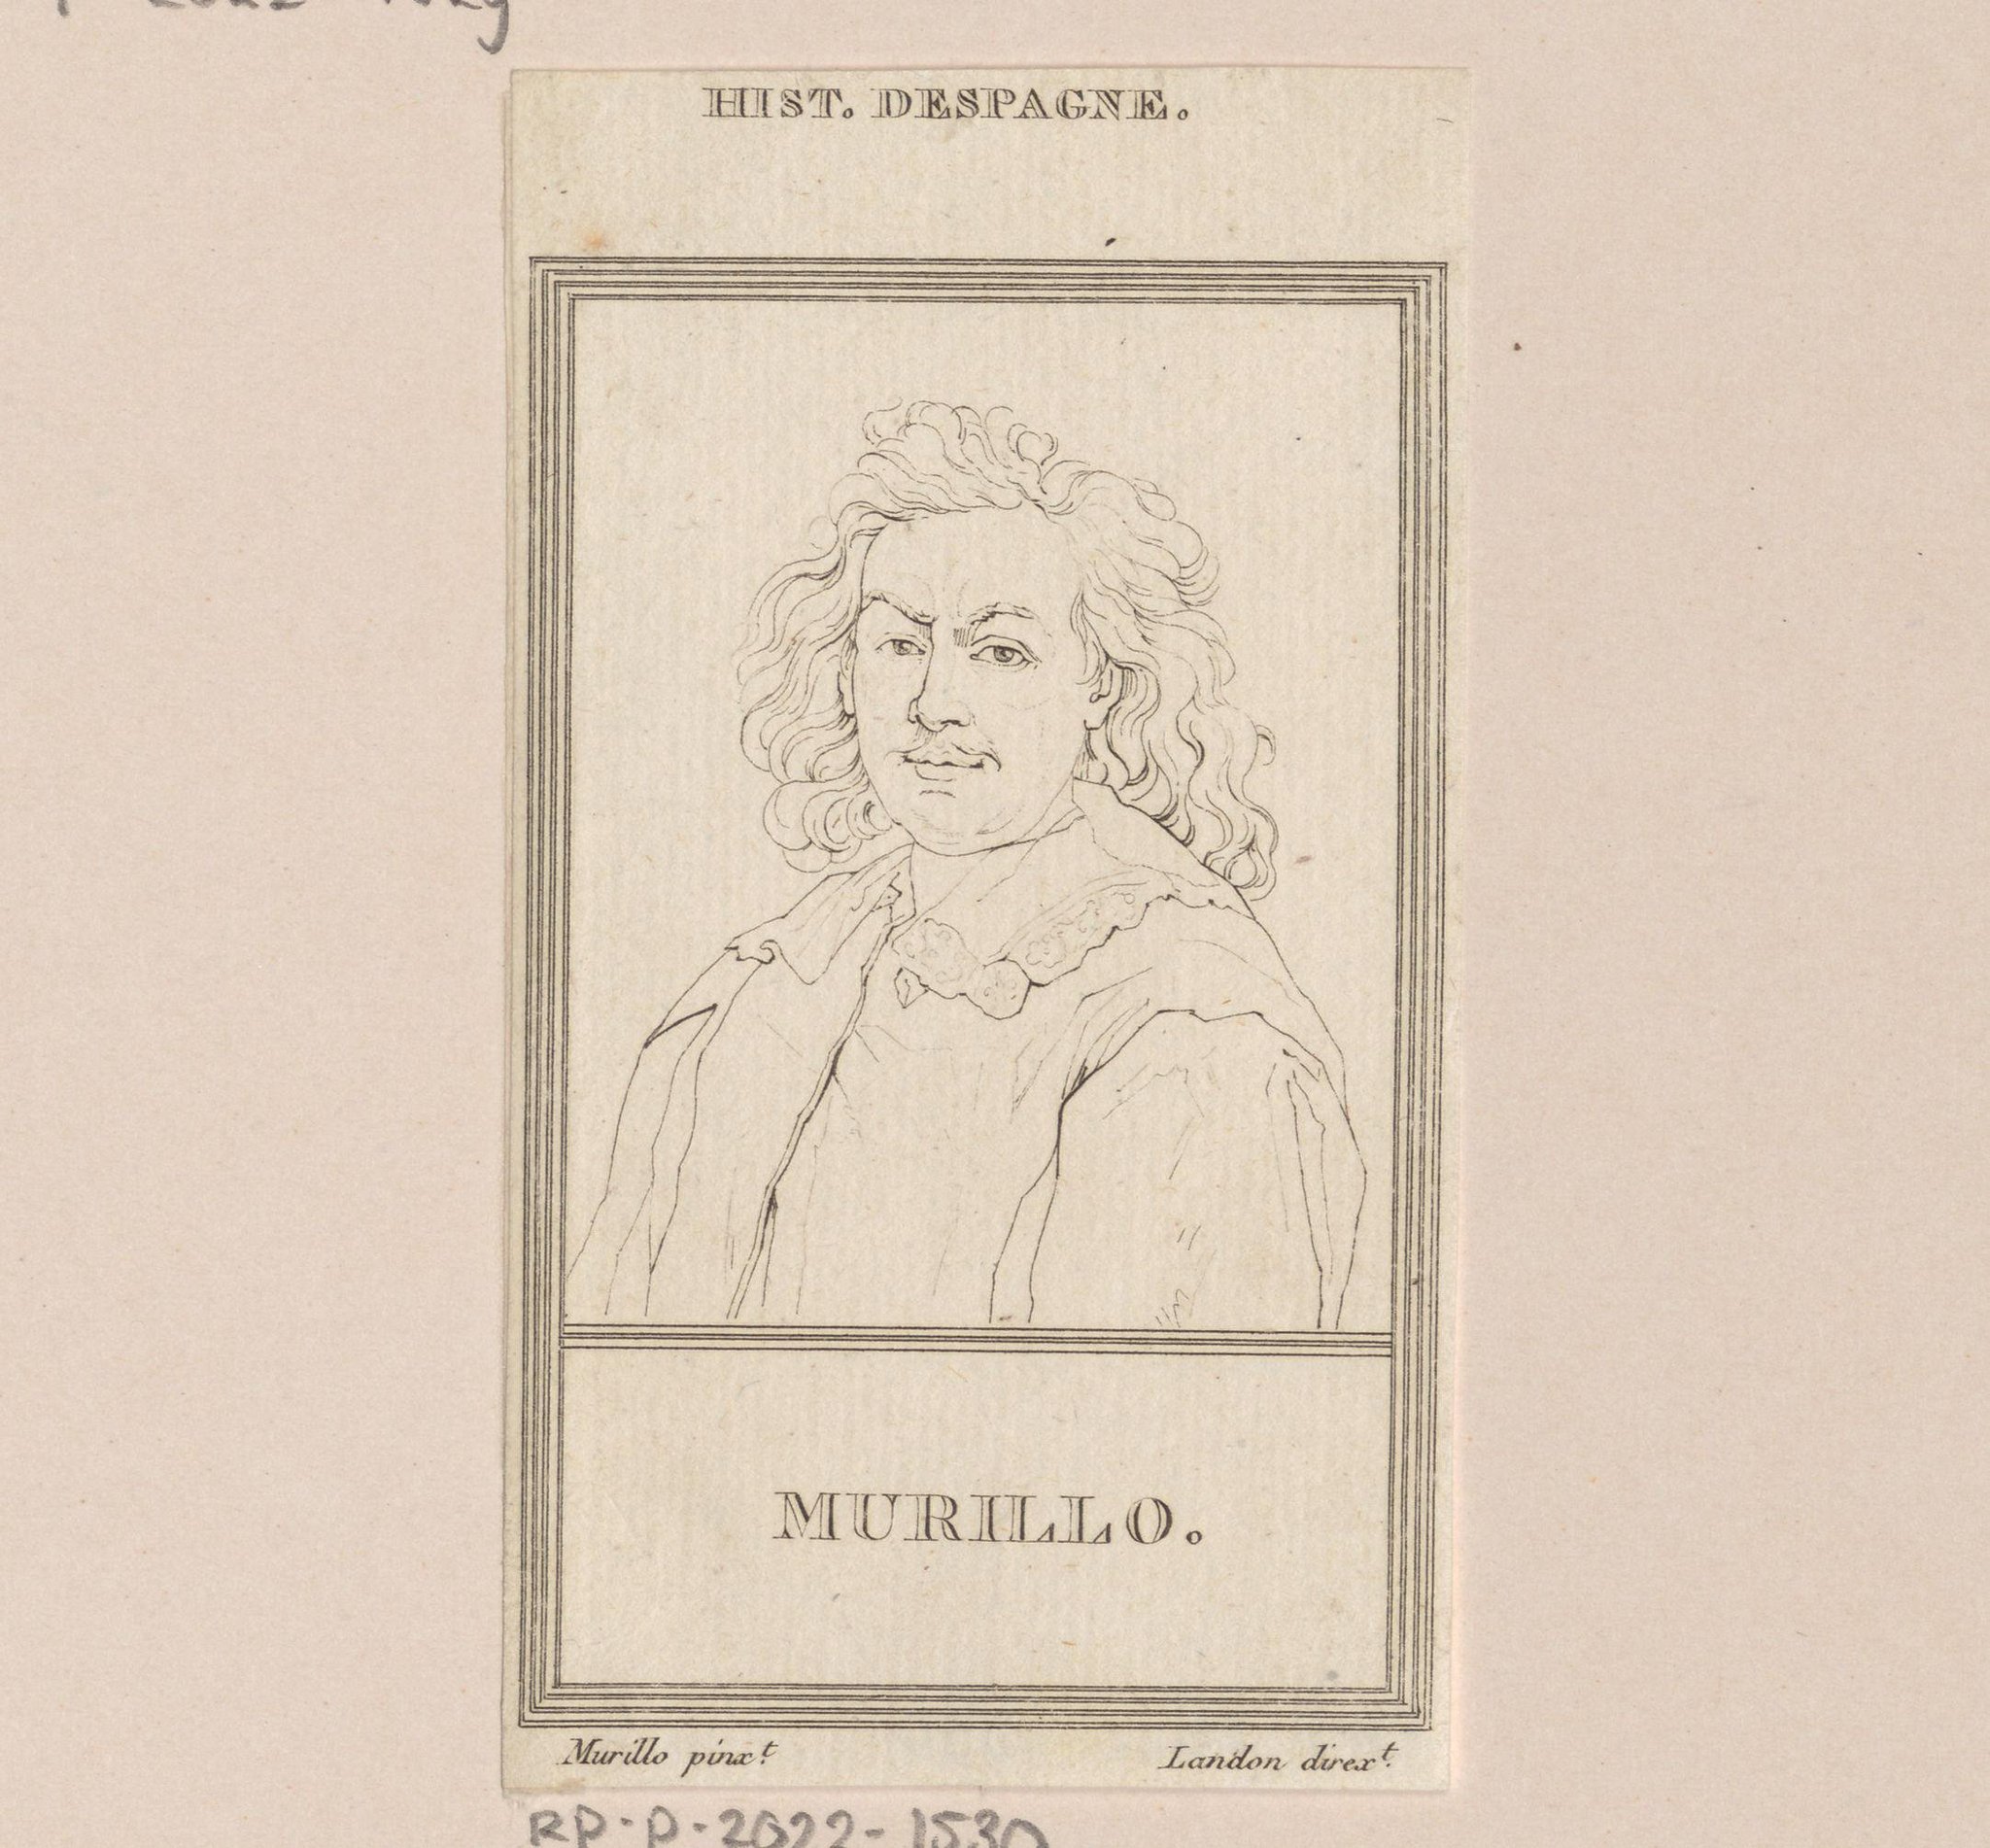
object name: print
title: Portret van Bartolomé Esteban Murillo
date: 1806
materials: paper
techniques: etching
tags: painter, draughtsman, bartolomé esteban murillo, historical persons, portrait of a writer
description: Prent waarschijnlijk uit: Landon, Charles Paul. Galerie historique des hommes les plus célèbres (...). Parijs: Imprimerie des Annales du Musée, 1806, dl. 8.